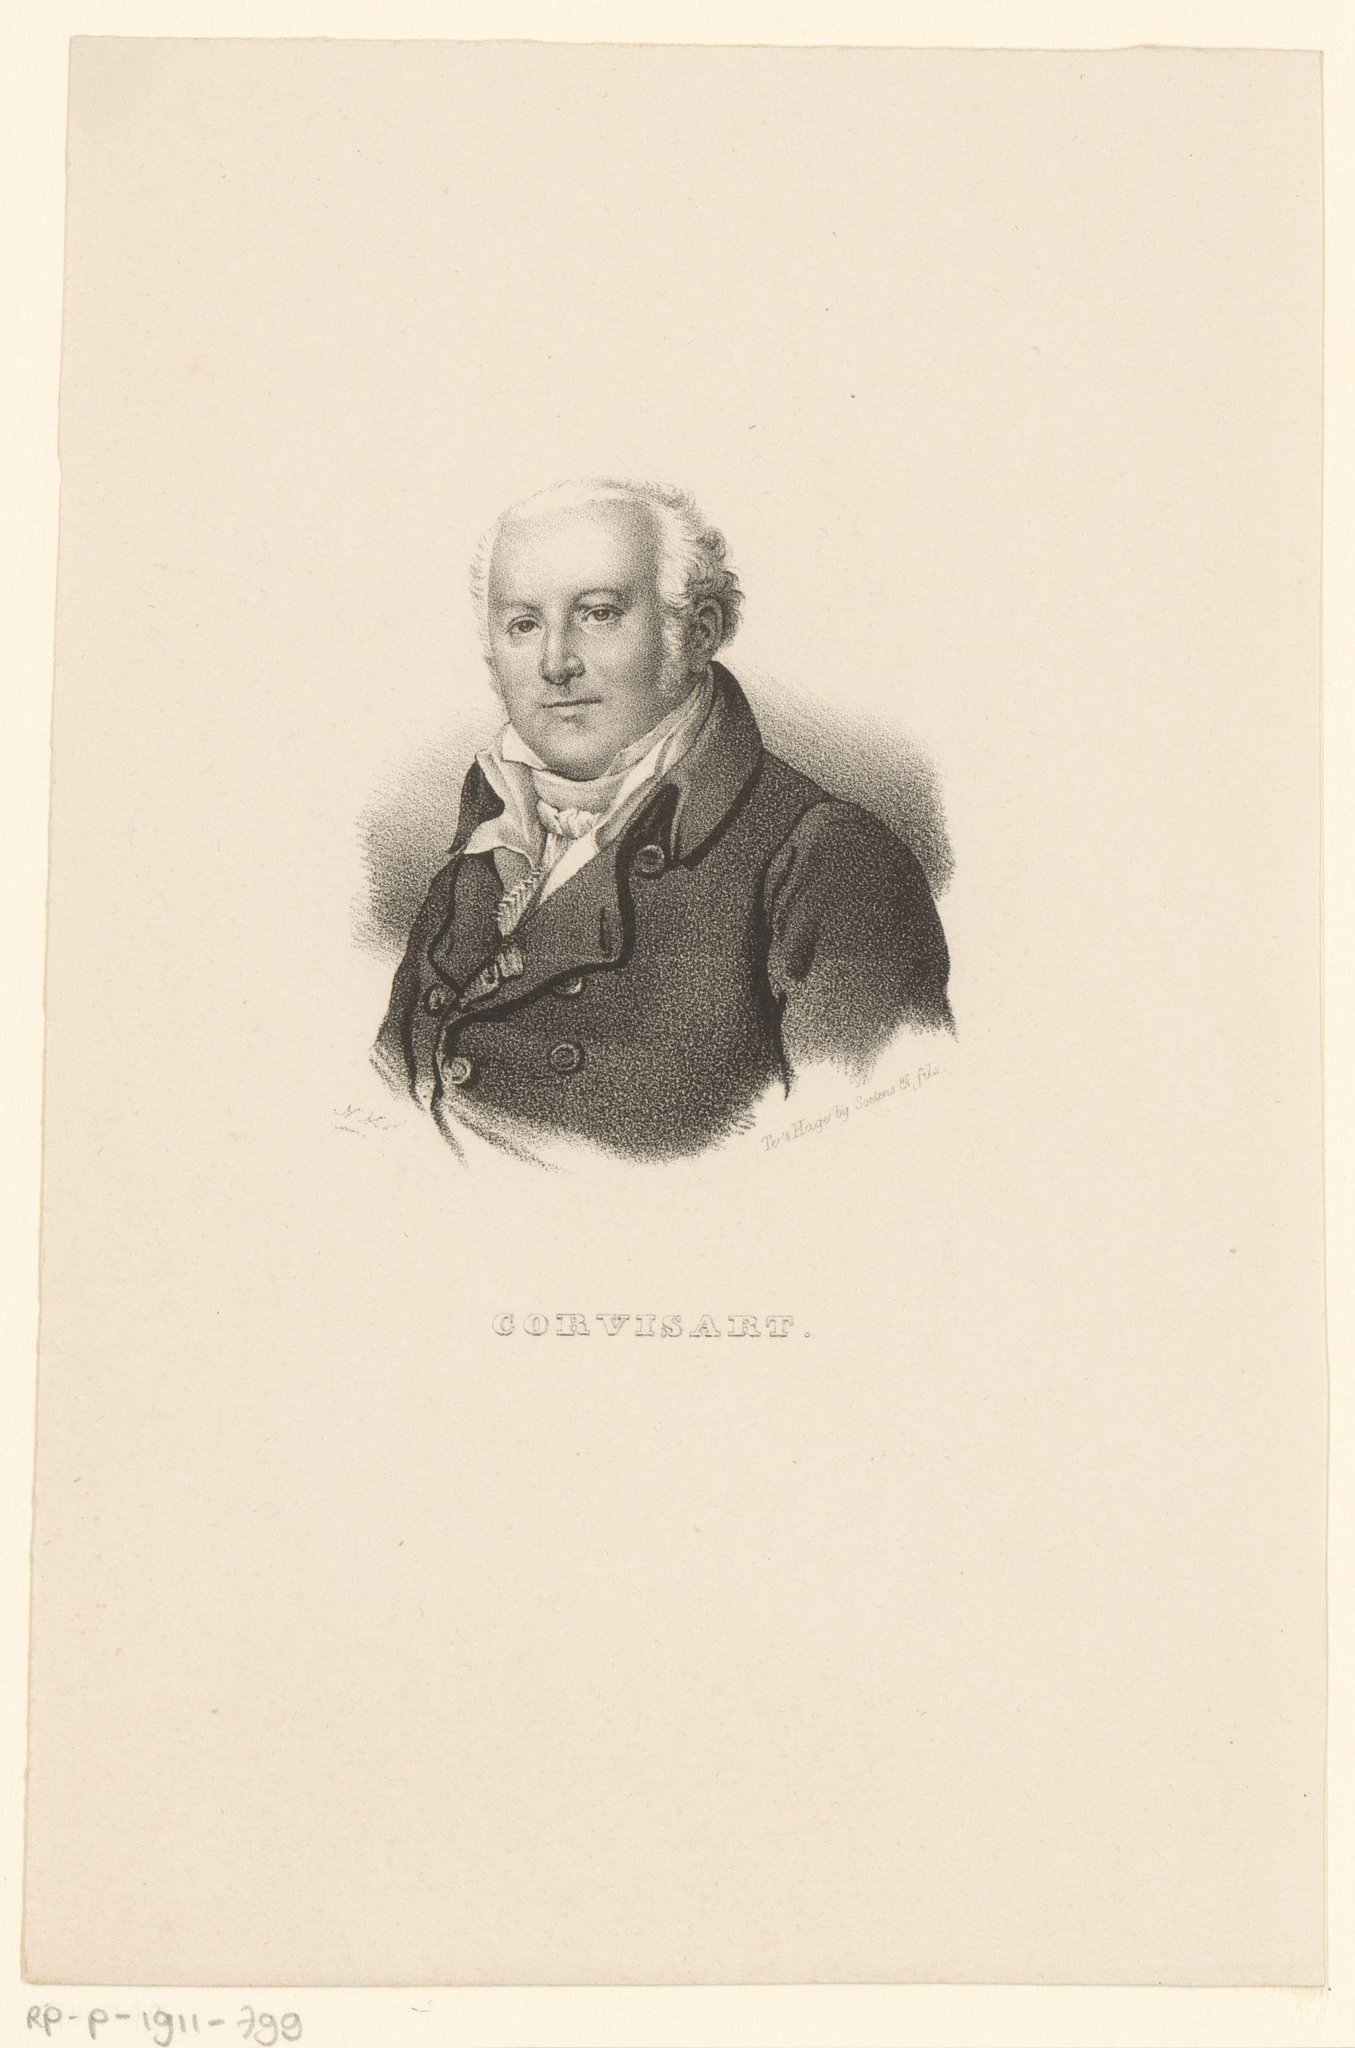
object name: print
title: Portret van Jean-Nicolas Corvisart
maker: nicolaas martinus schild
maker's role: draughtsman, print maker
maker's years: 1822-1840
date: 1837-1840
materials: paper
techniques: lithograph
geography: the hague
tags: historical persons (+ (full) bust portrait)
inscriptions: collector's mark: Lugt 2228